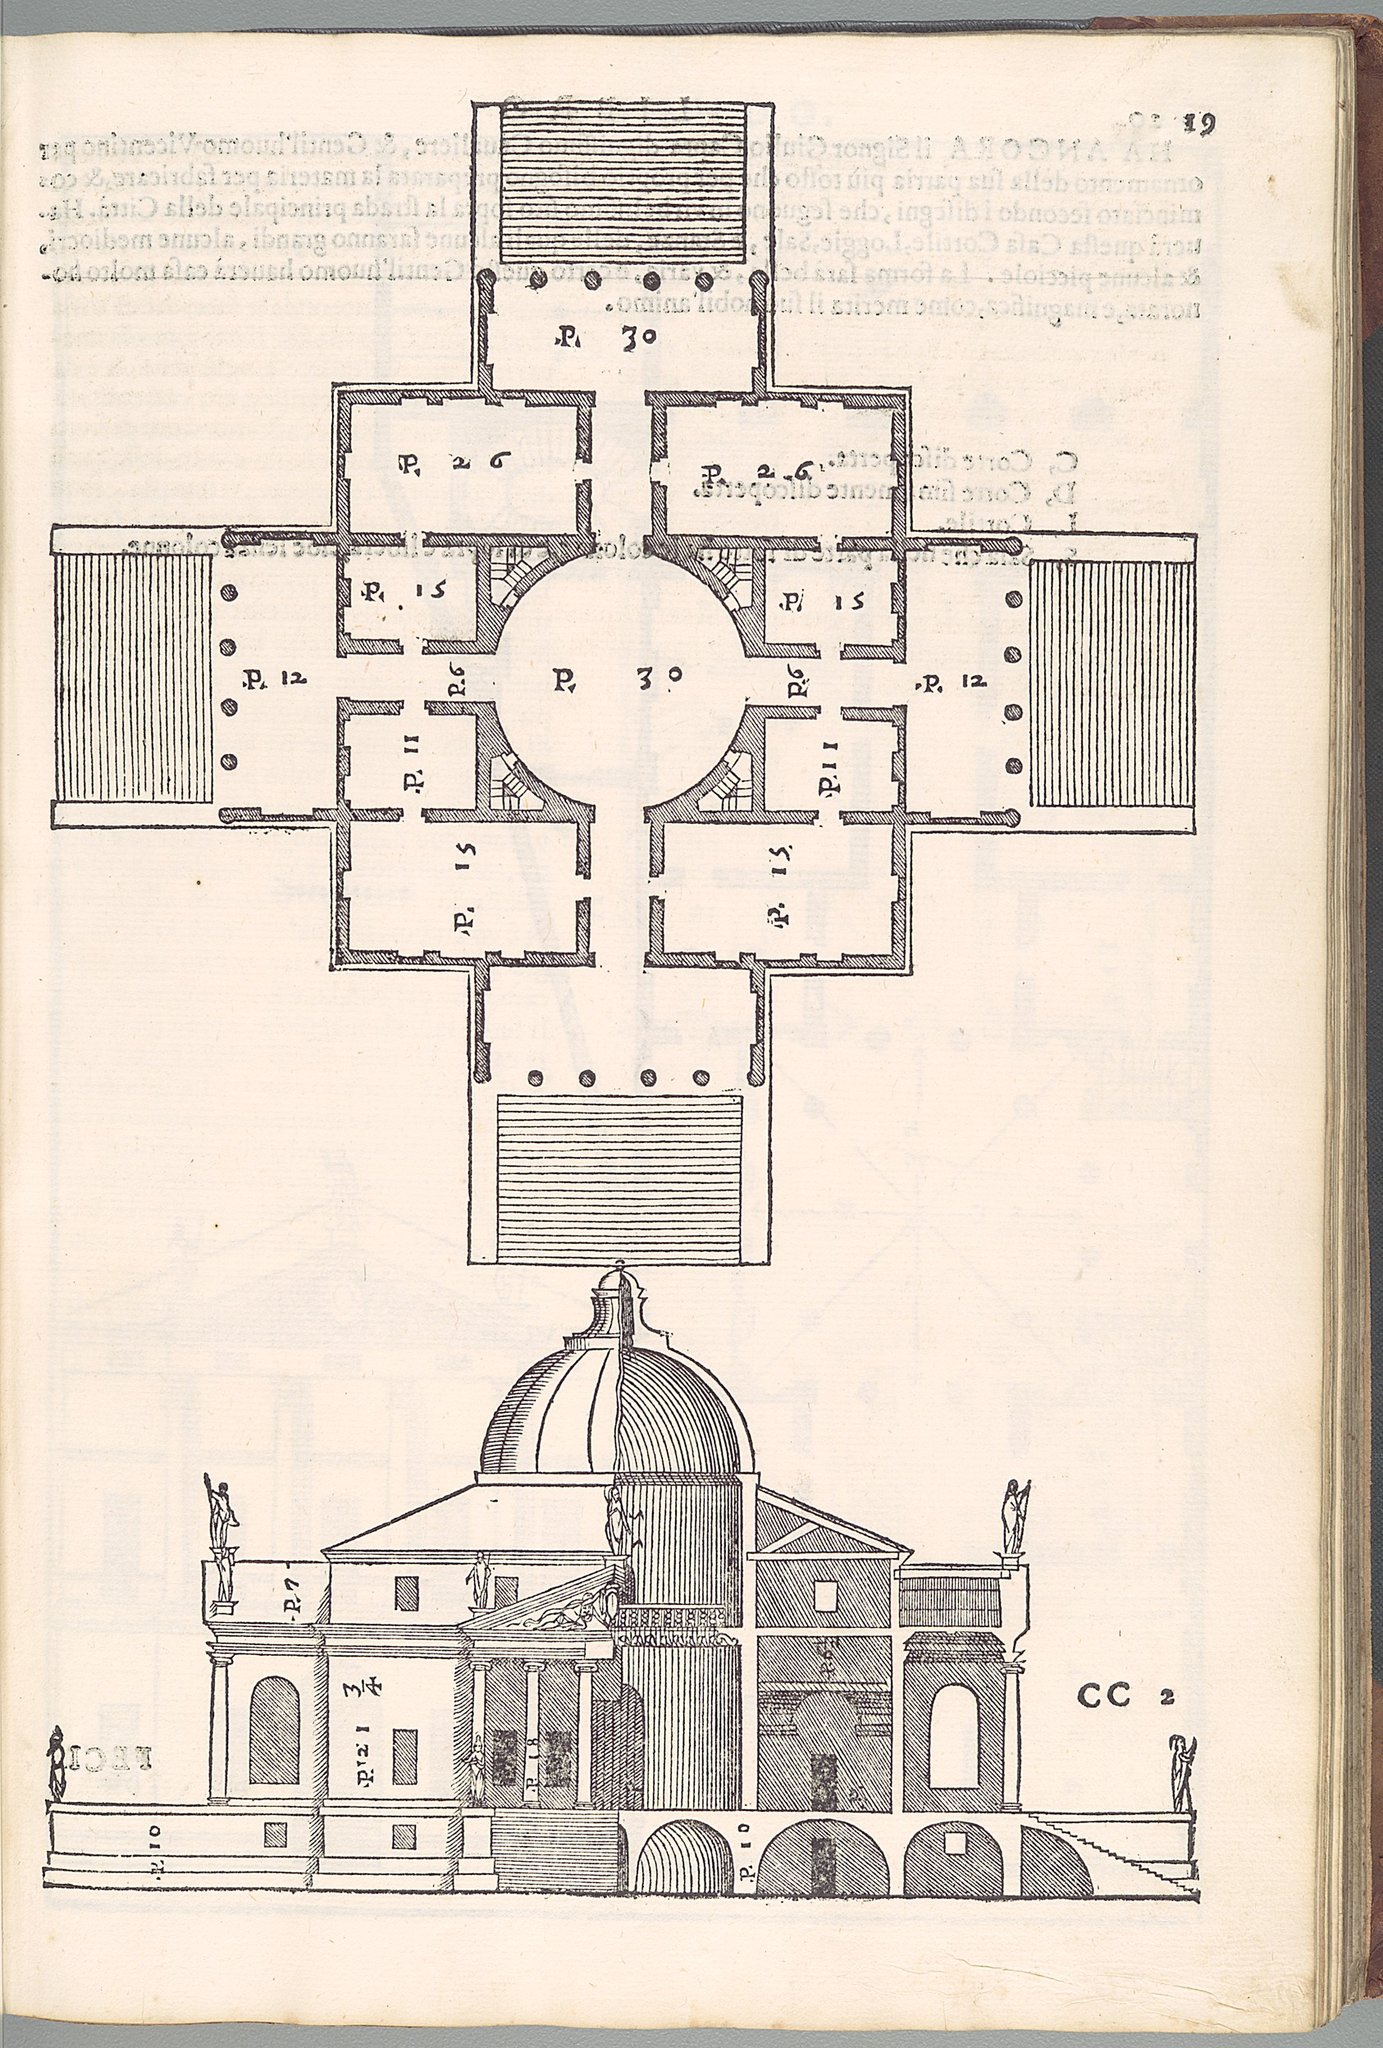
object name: book print ornament architecture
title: I quattro libri dell'architettura di Andrea Palladio. Ne'quale dopo un breue trattato de' cinque ordini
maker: andrea palladio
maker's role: author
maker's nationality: italian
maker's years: 1508-1580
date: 1581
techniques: printing, woodcut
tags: architecture